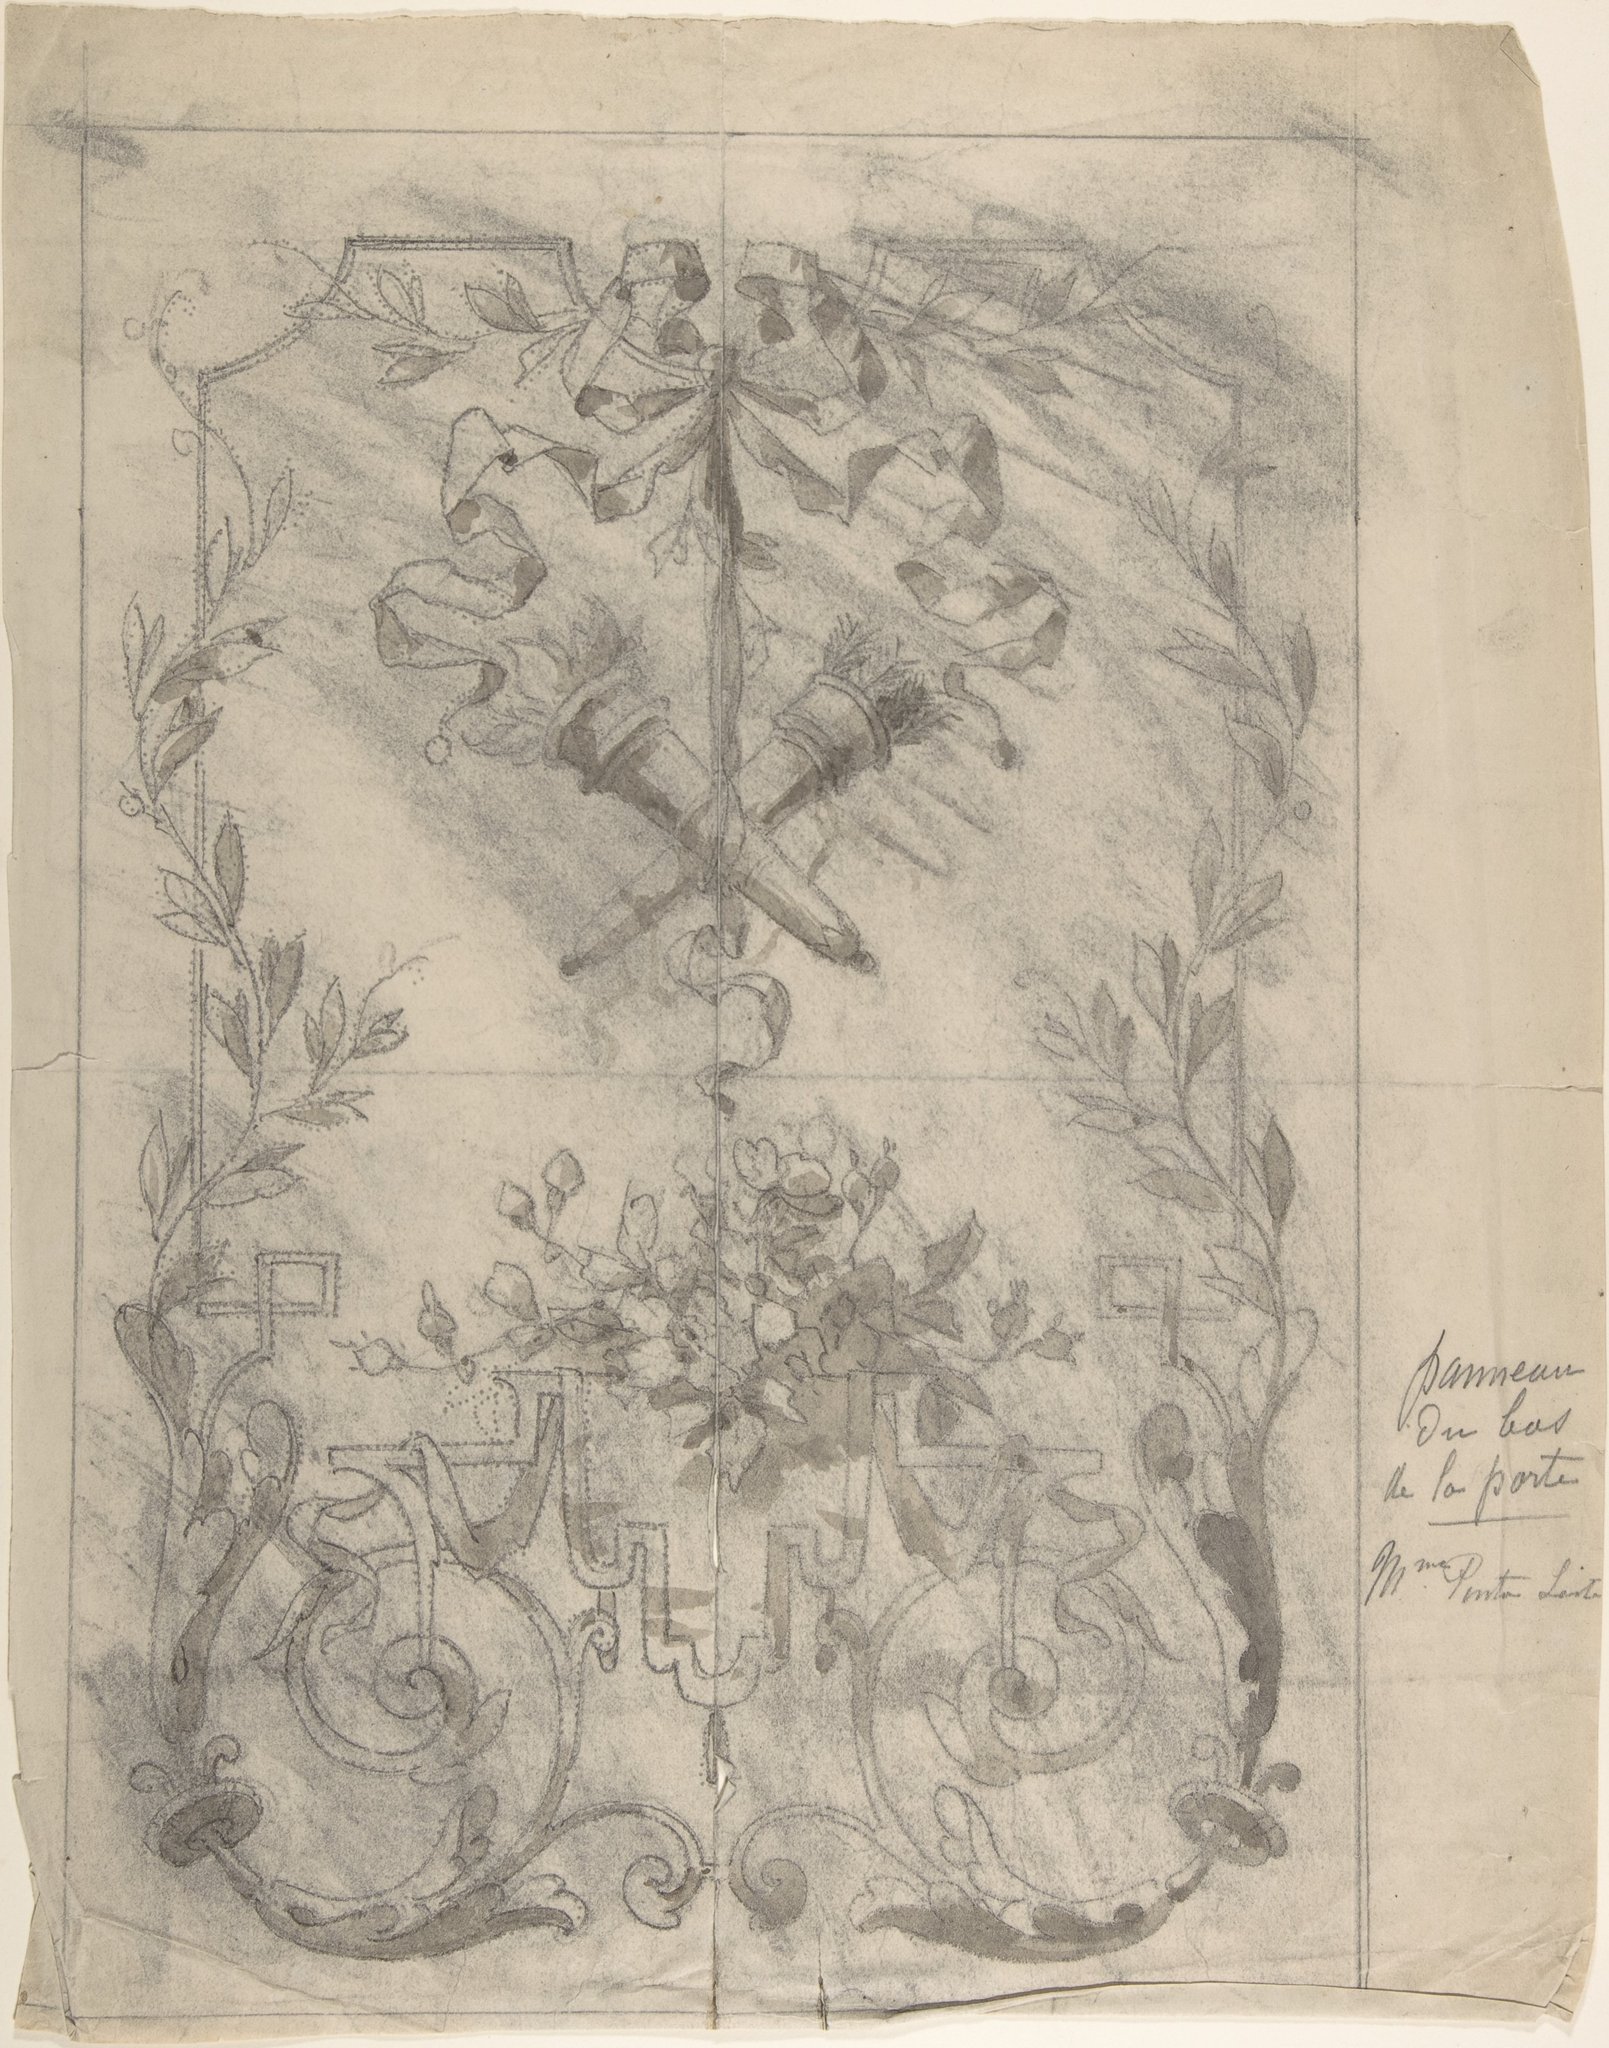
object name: drawing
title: Design for Door Paneling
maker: charles monblond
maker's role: artist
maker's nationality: french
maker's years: 1800-1900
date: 1801-1900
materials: graphite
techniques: wash